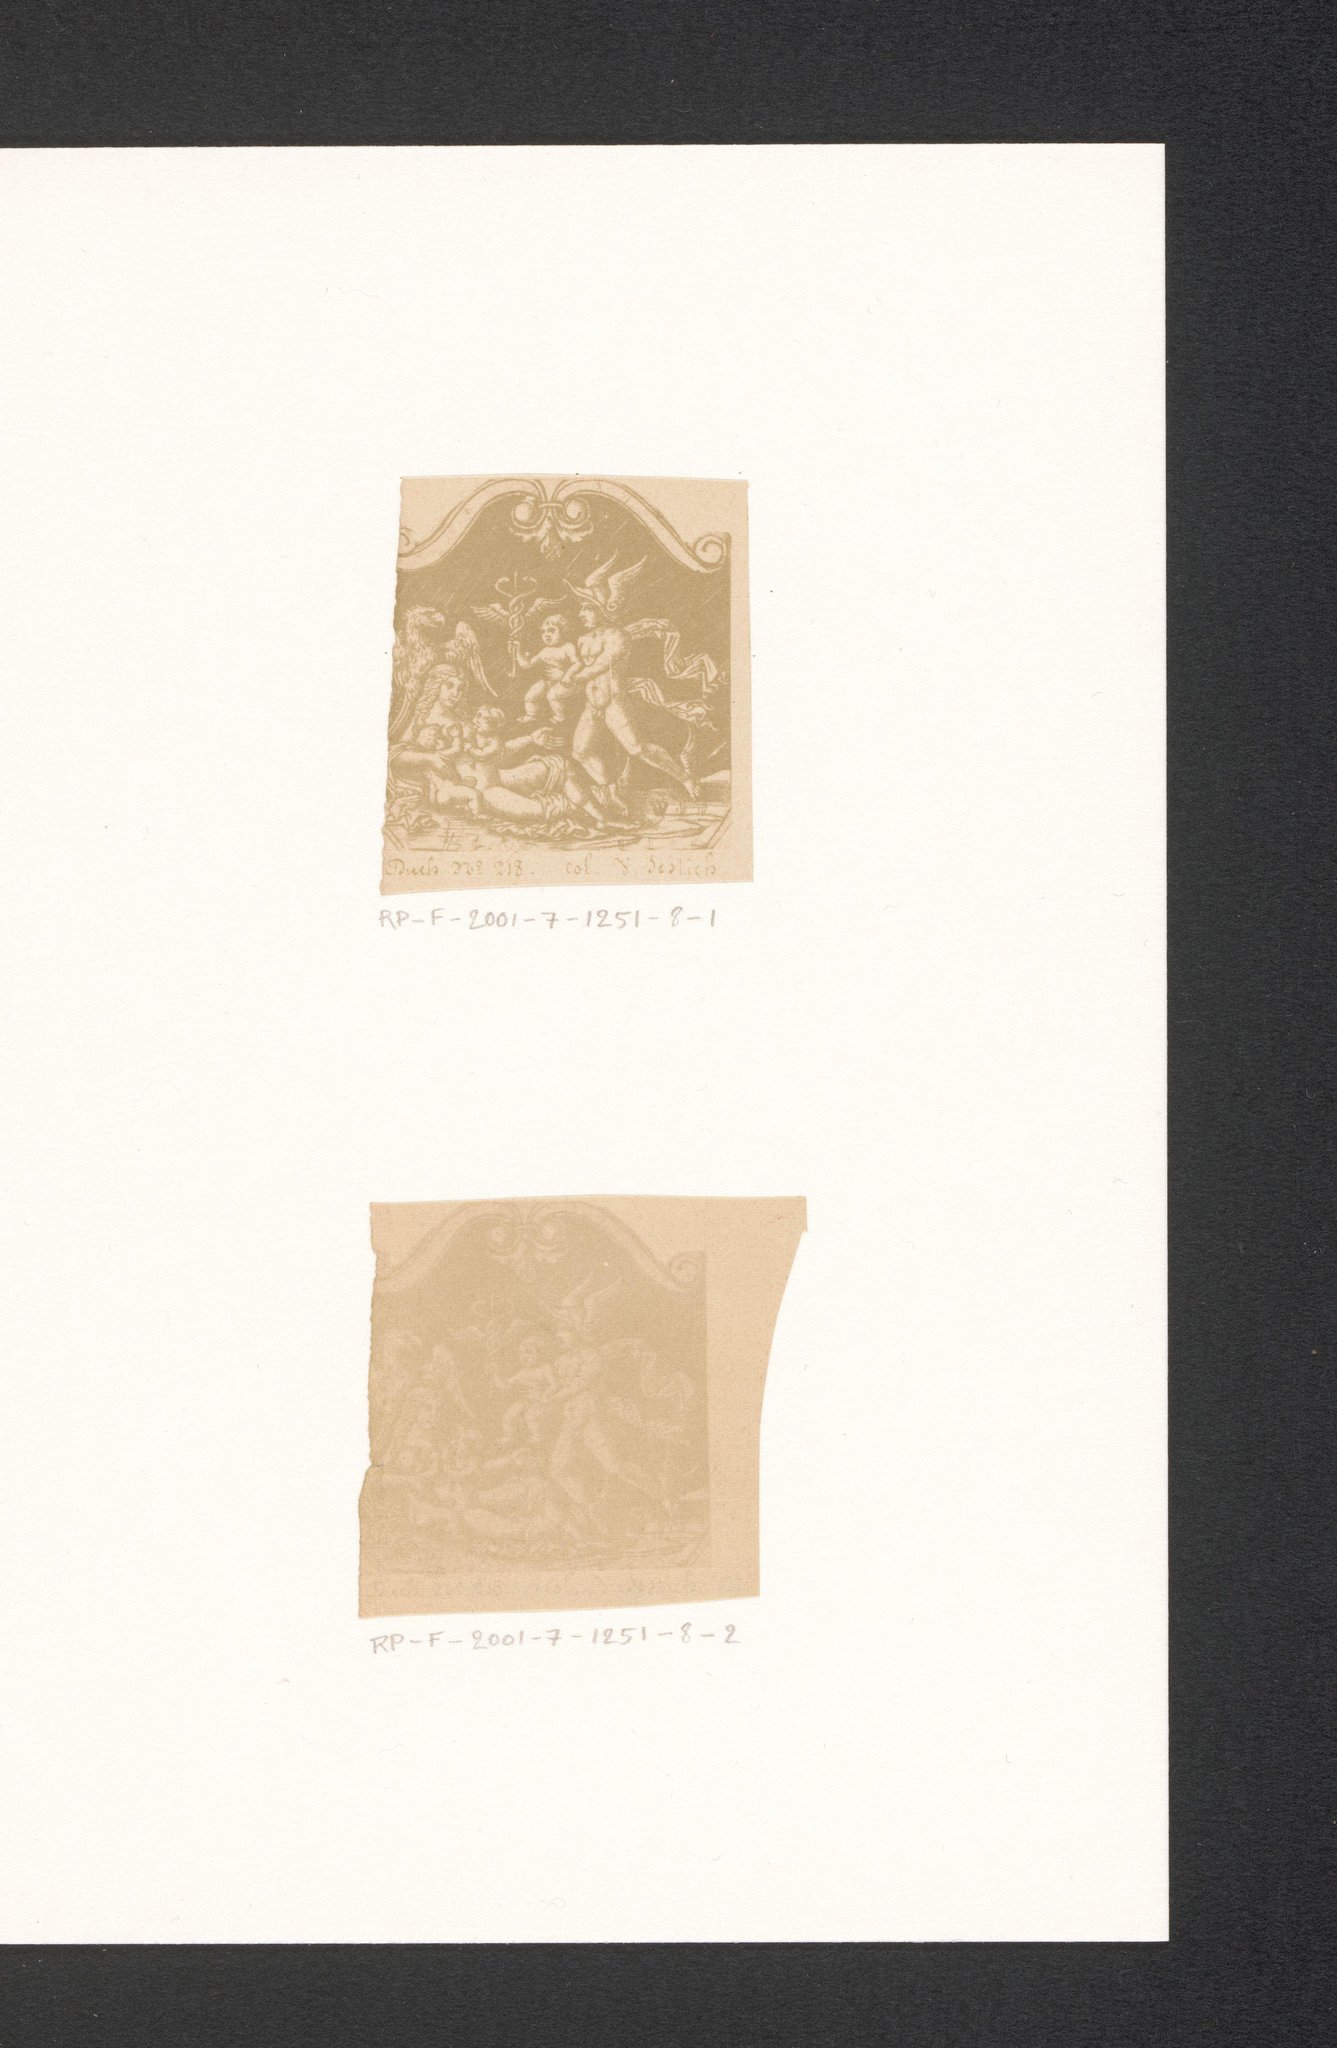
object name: photograph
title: Fotoreproductie van een prent van Mercurius die het kind Bacchus aan de nimfen van Nysa geeft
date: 1852-1857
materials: photographic support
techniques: salted paper print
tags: mercury hands the baby bacchus over to the nymphs of nysa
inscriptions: inscription: ‘Duch. [No. 218.] col. [V.] Ses[tich]’